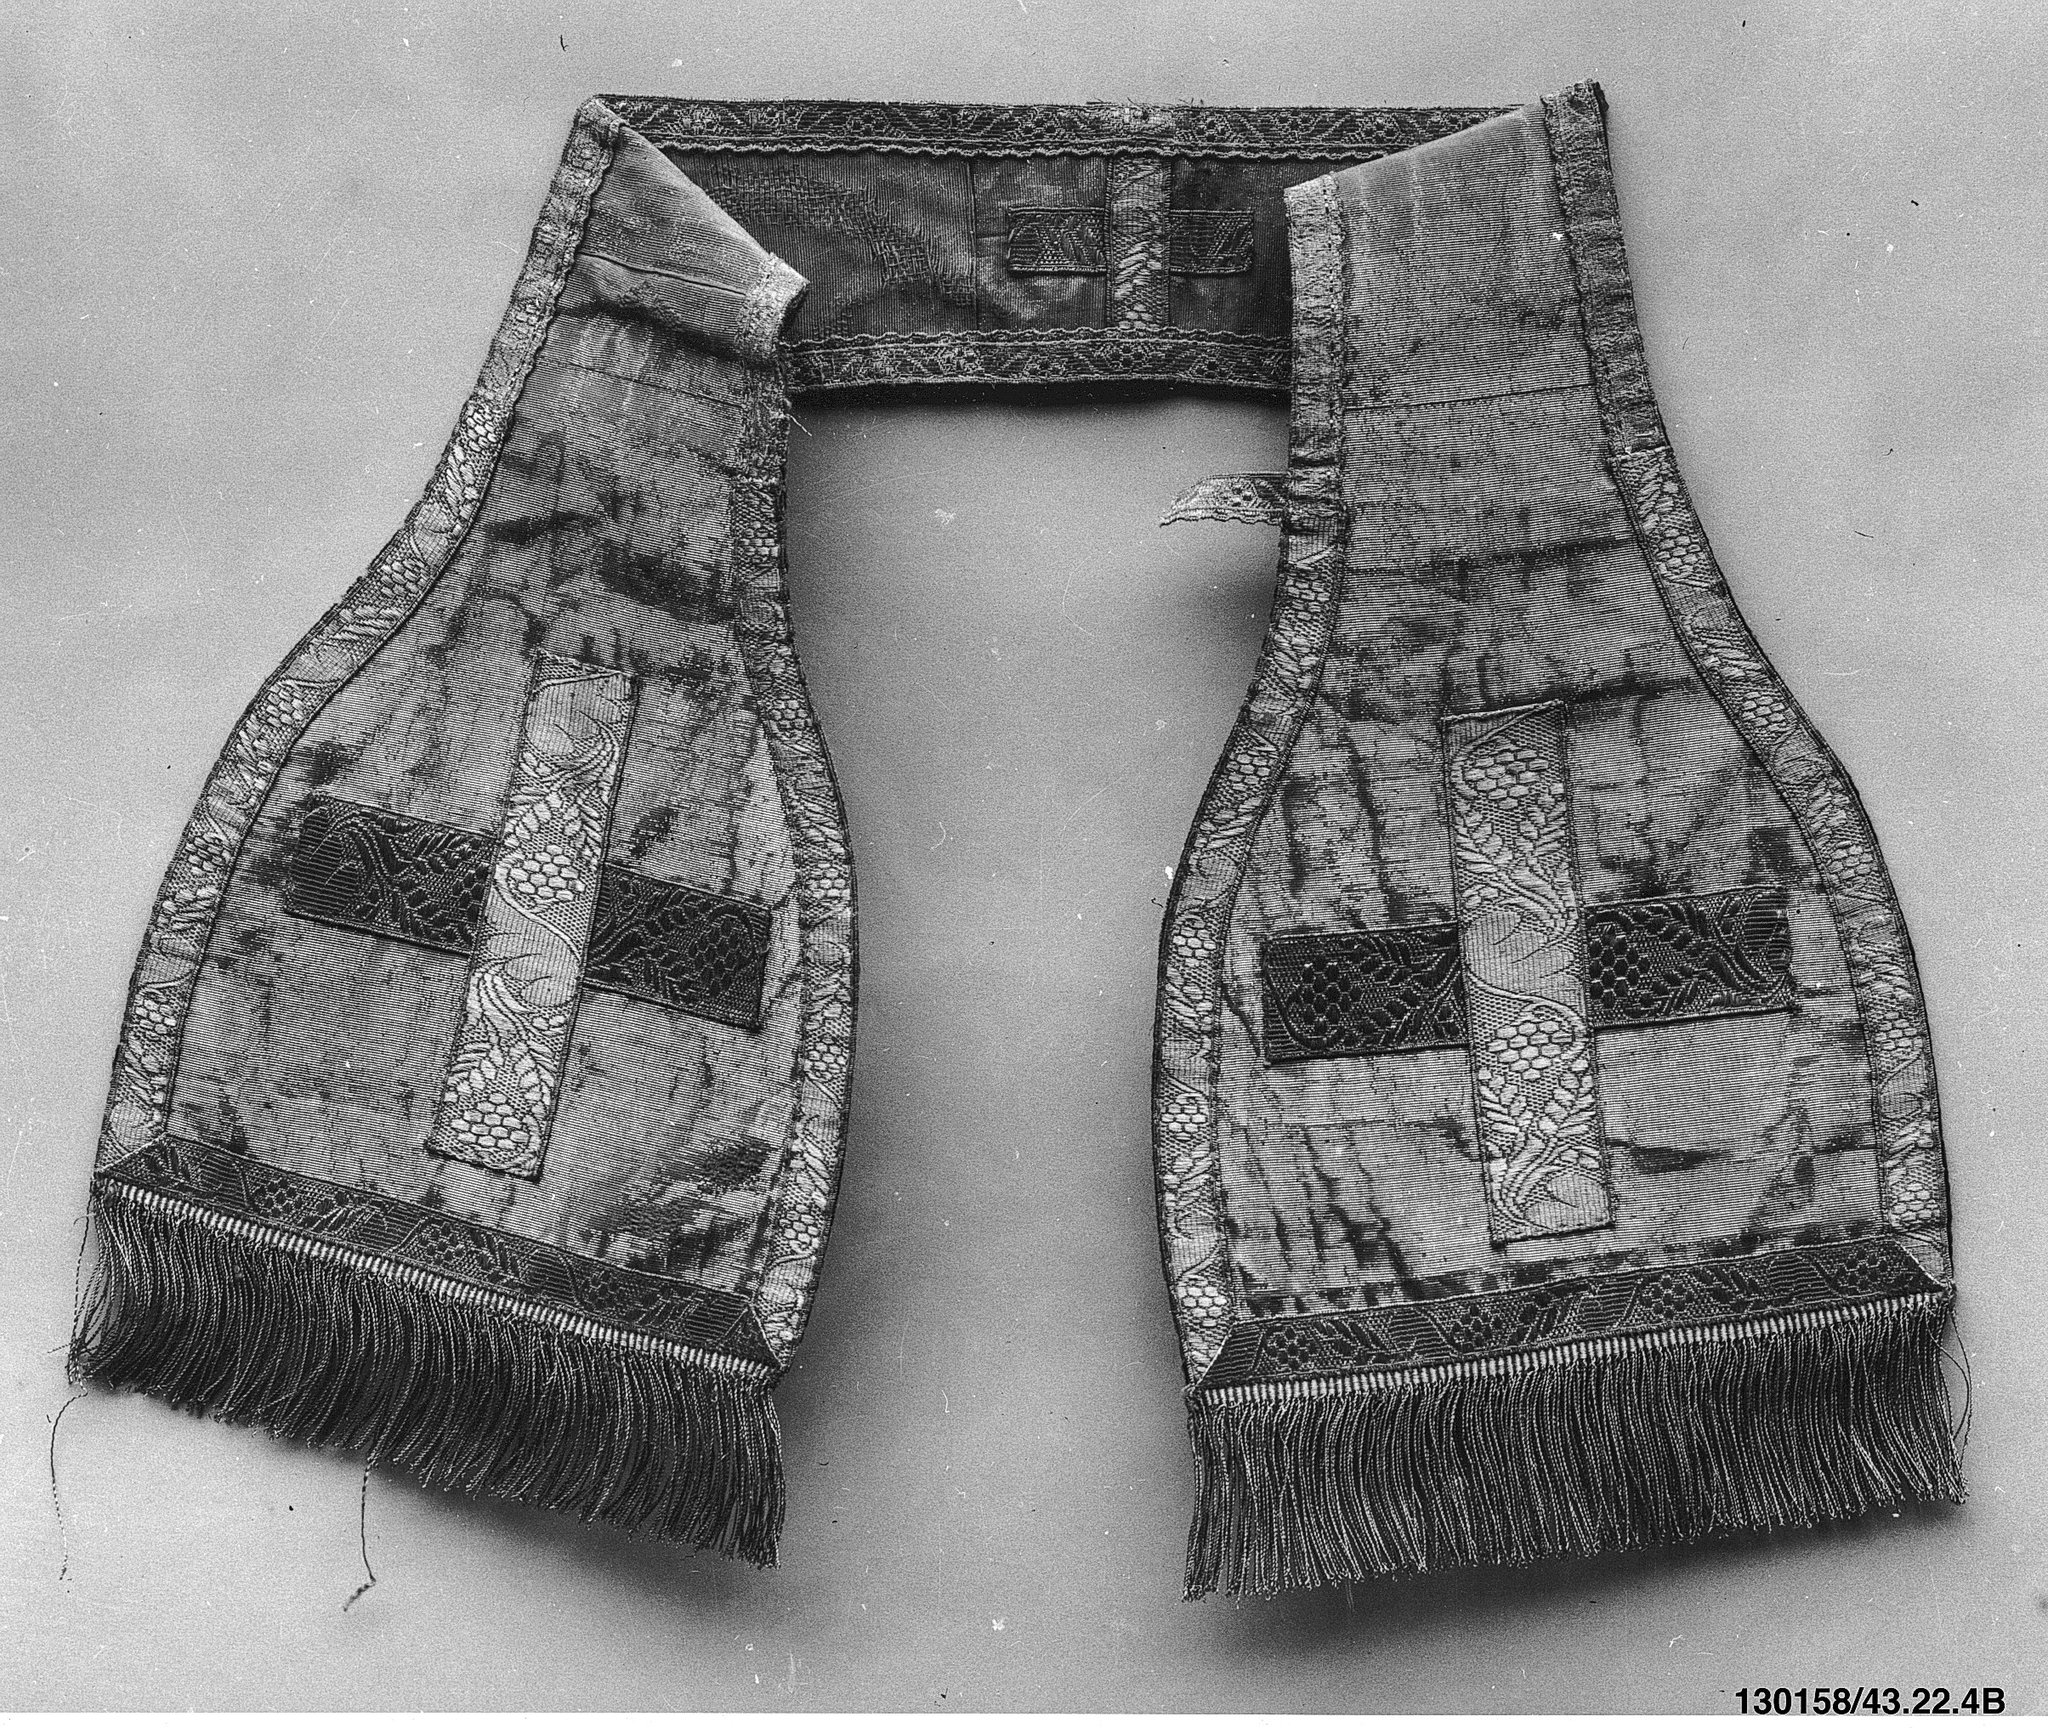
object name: maniple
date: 1801-1900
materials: metal thread, silk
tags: cross